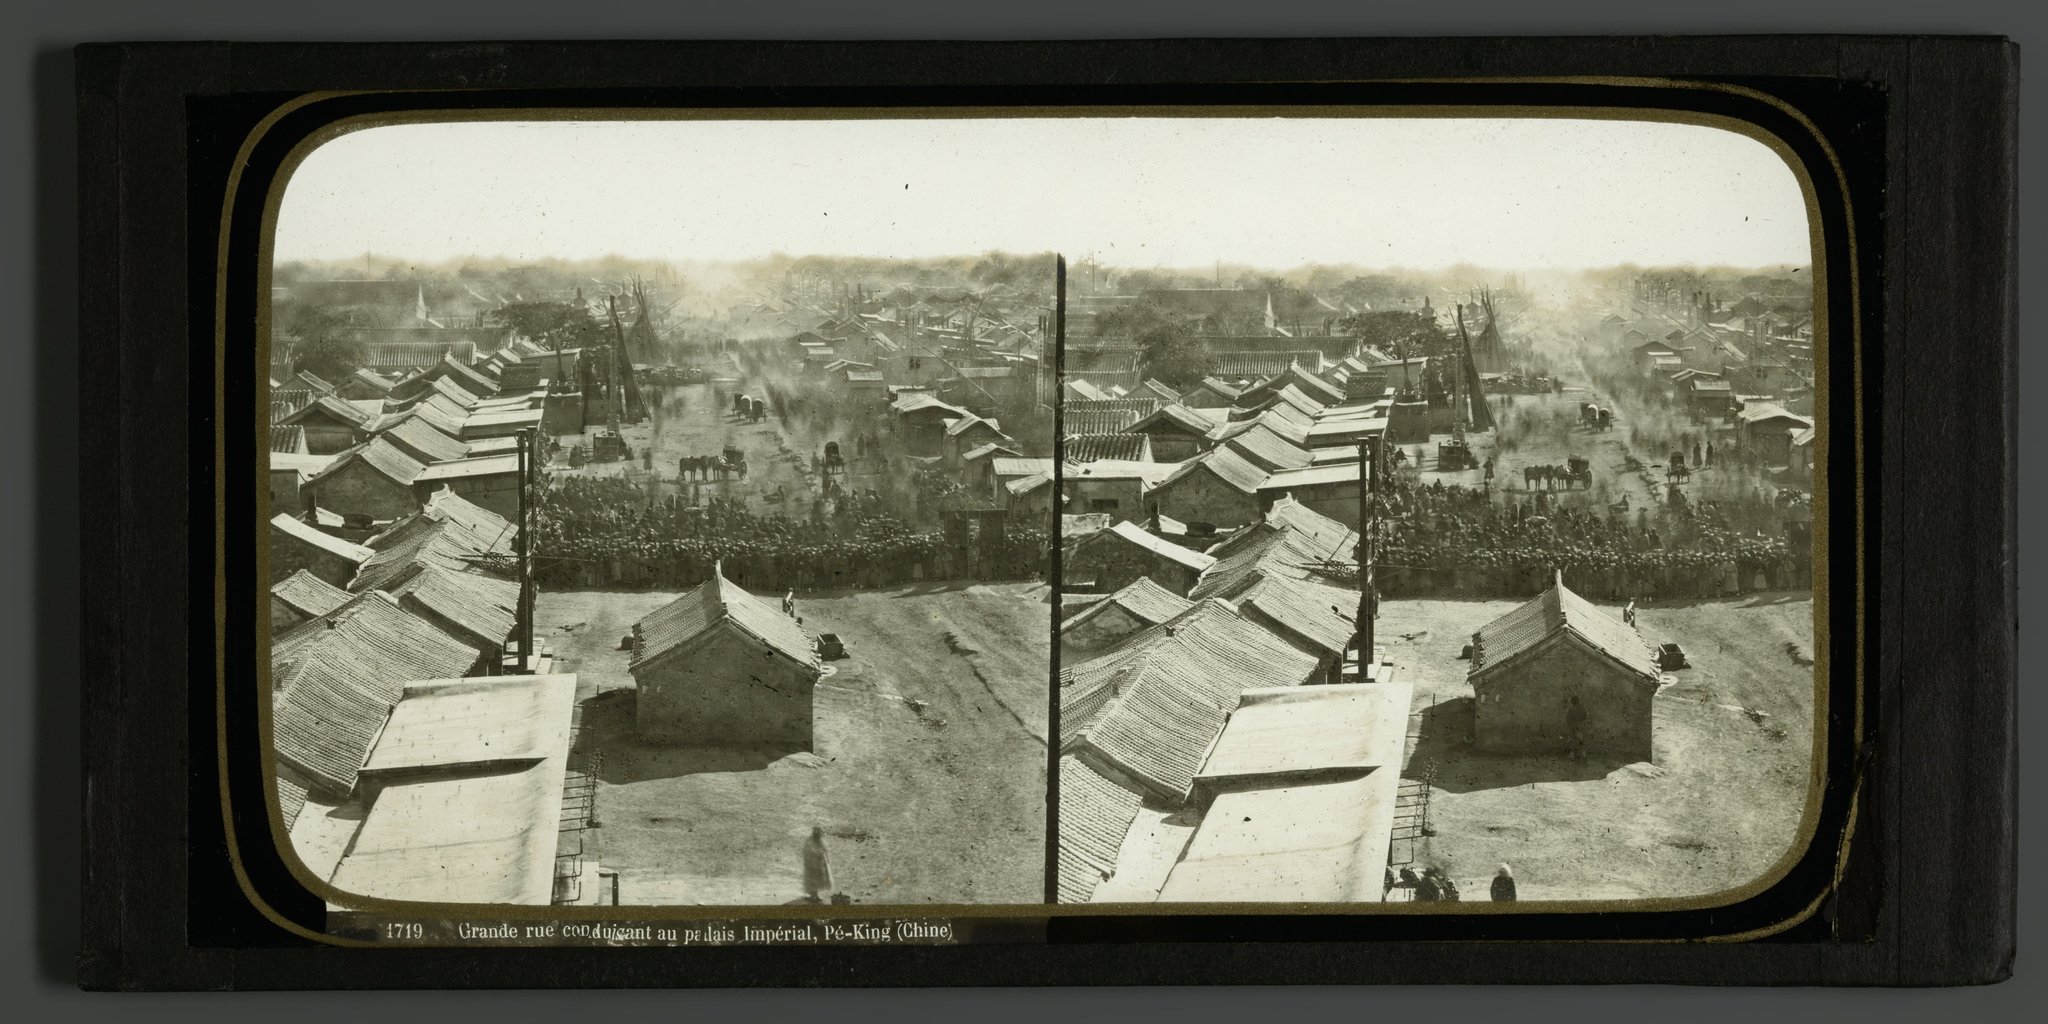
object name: stereoscopic photograph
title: Gezicht op de weg naar het keizerlijk paleis te Peking, China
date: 1864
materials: glass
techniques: slide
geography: beijing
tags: city-view in general; 'veduta', public road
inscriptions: number: ‘1719’